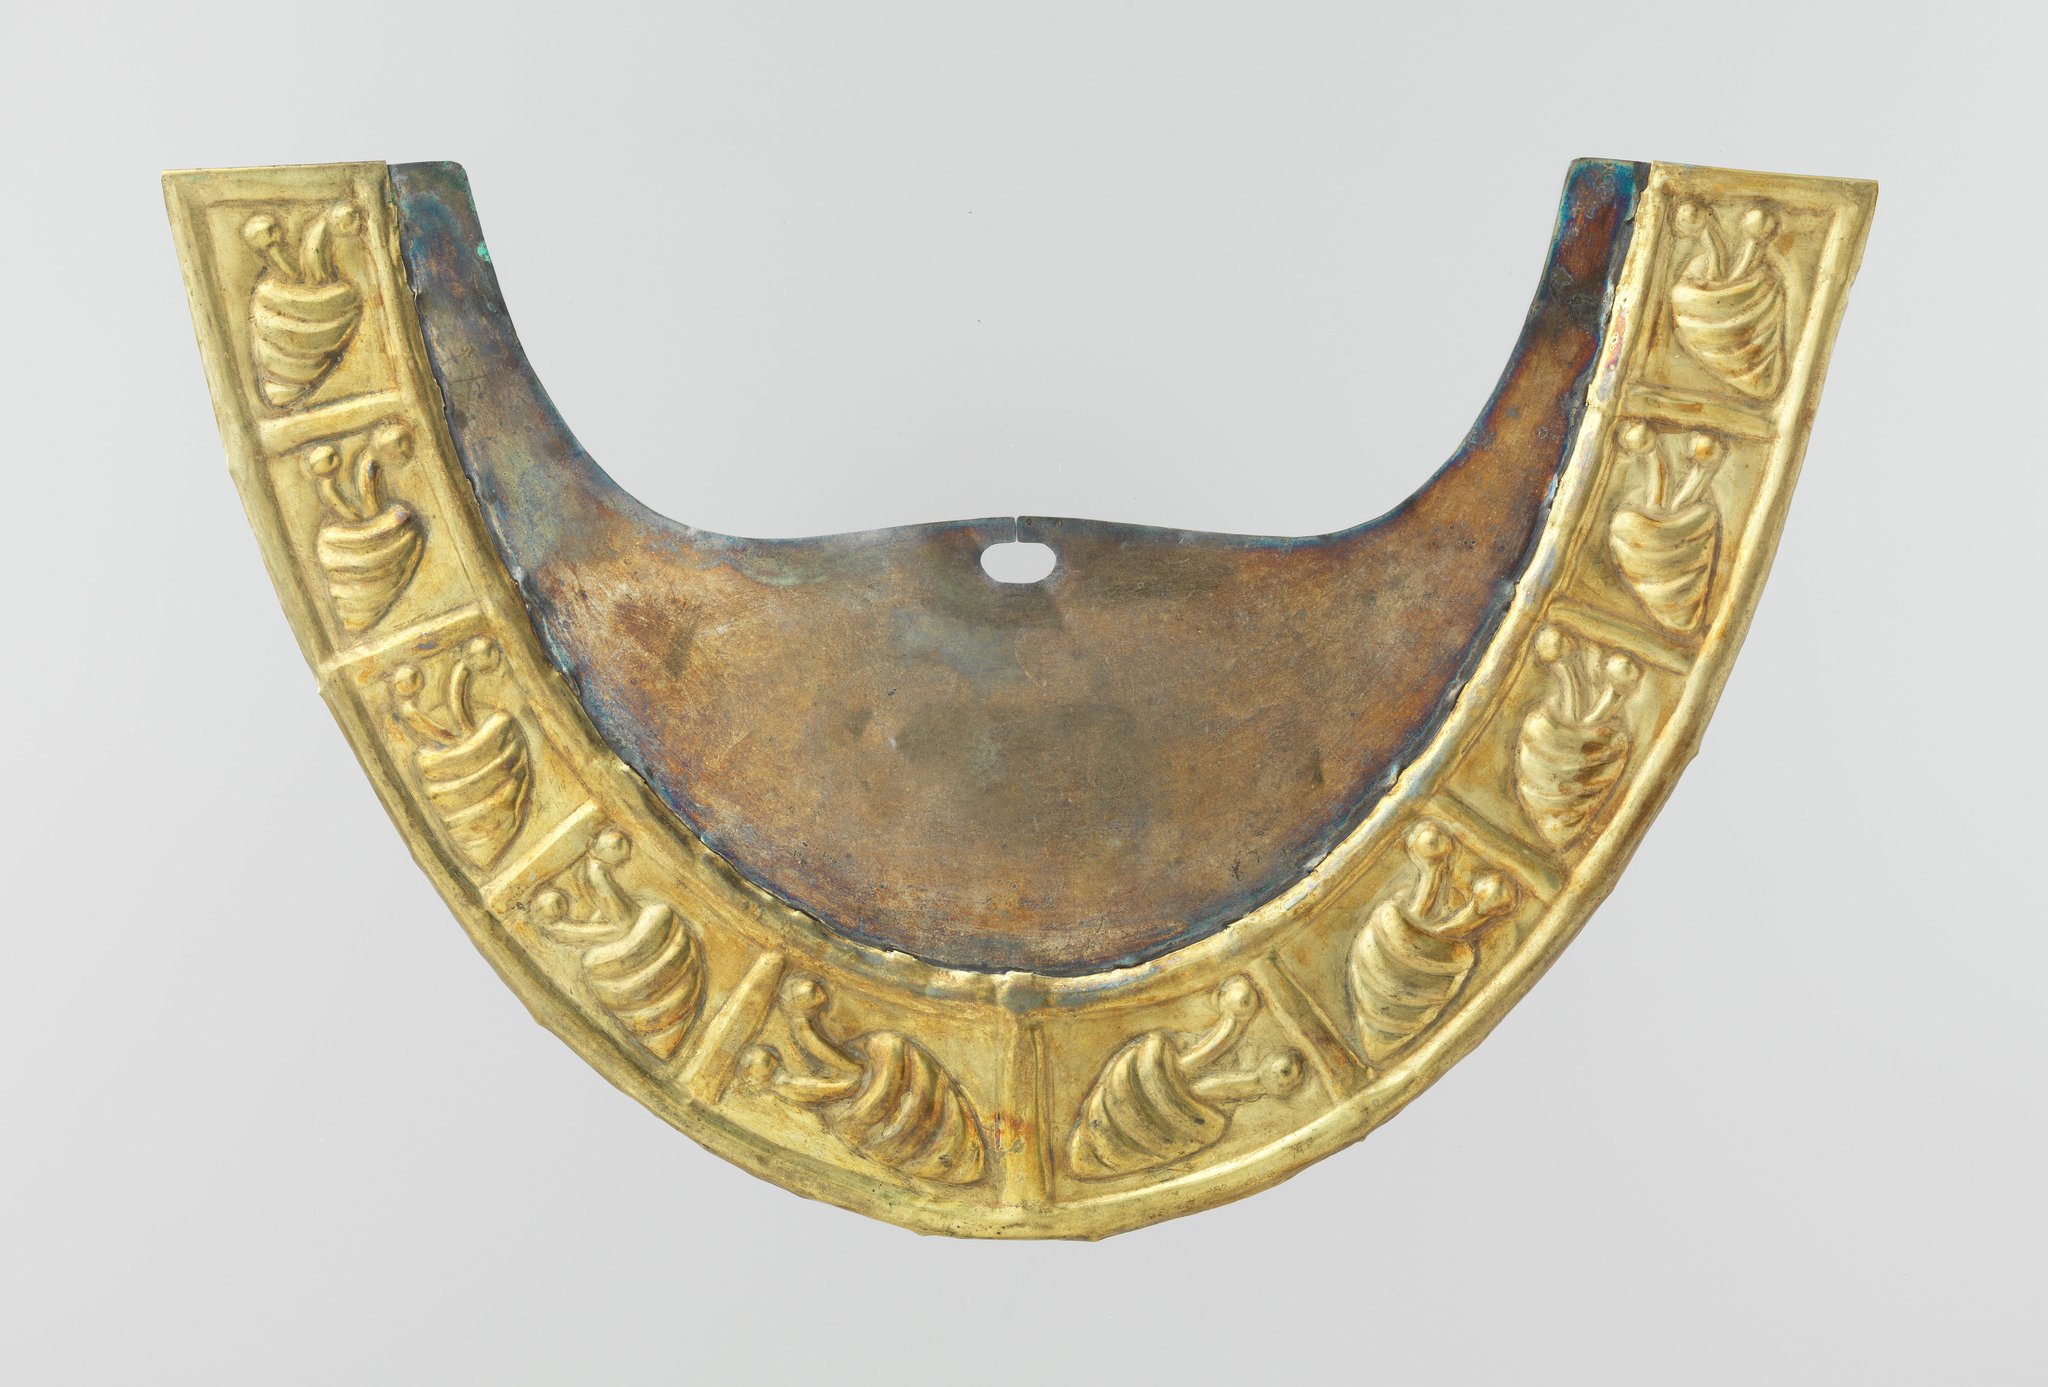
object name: nose ornament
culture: moche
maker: moche artist(s)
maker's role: artist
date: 500-800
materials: gold, silver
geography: peru